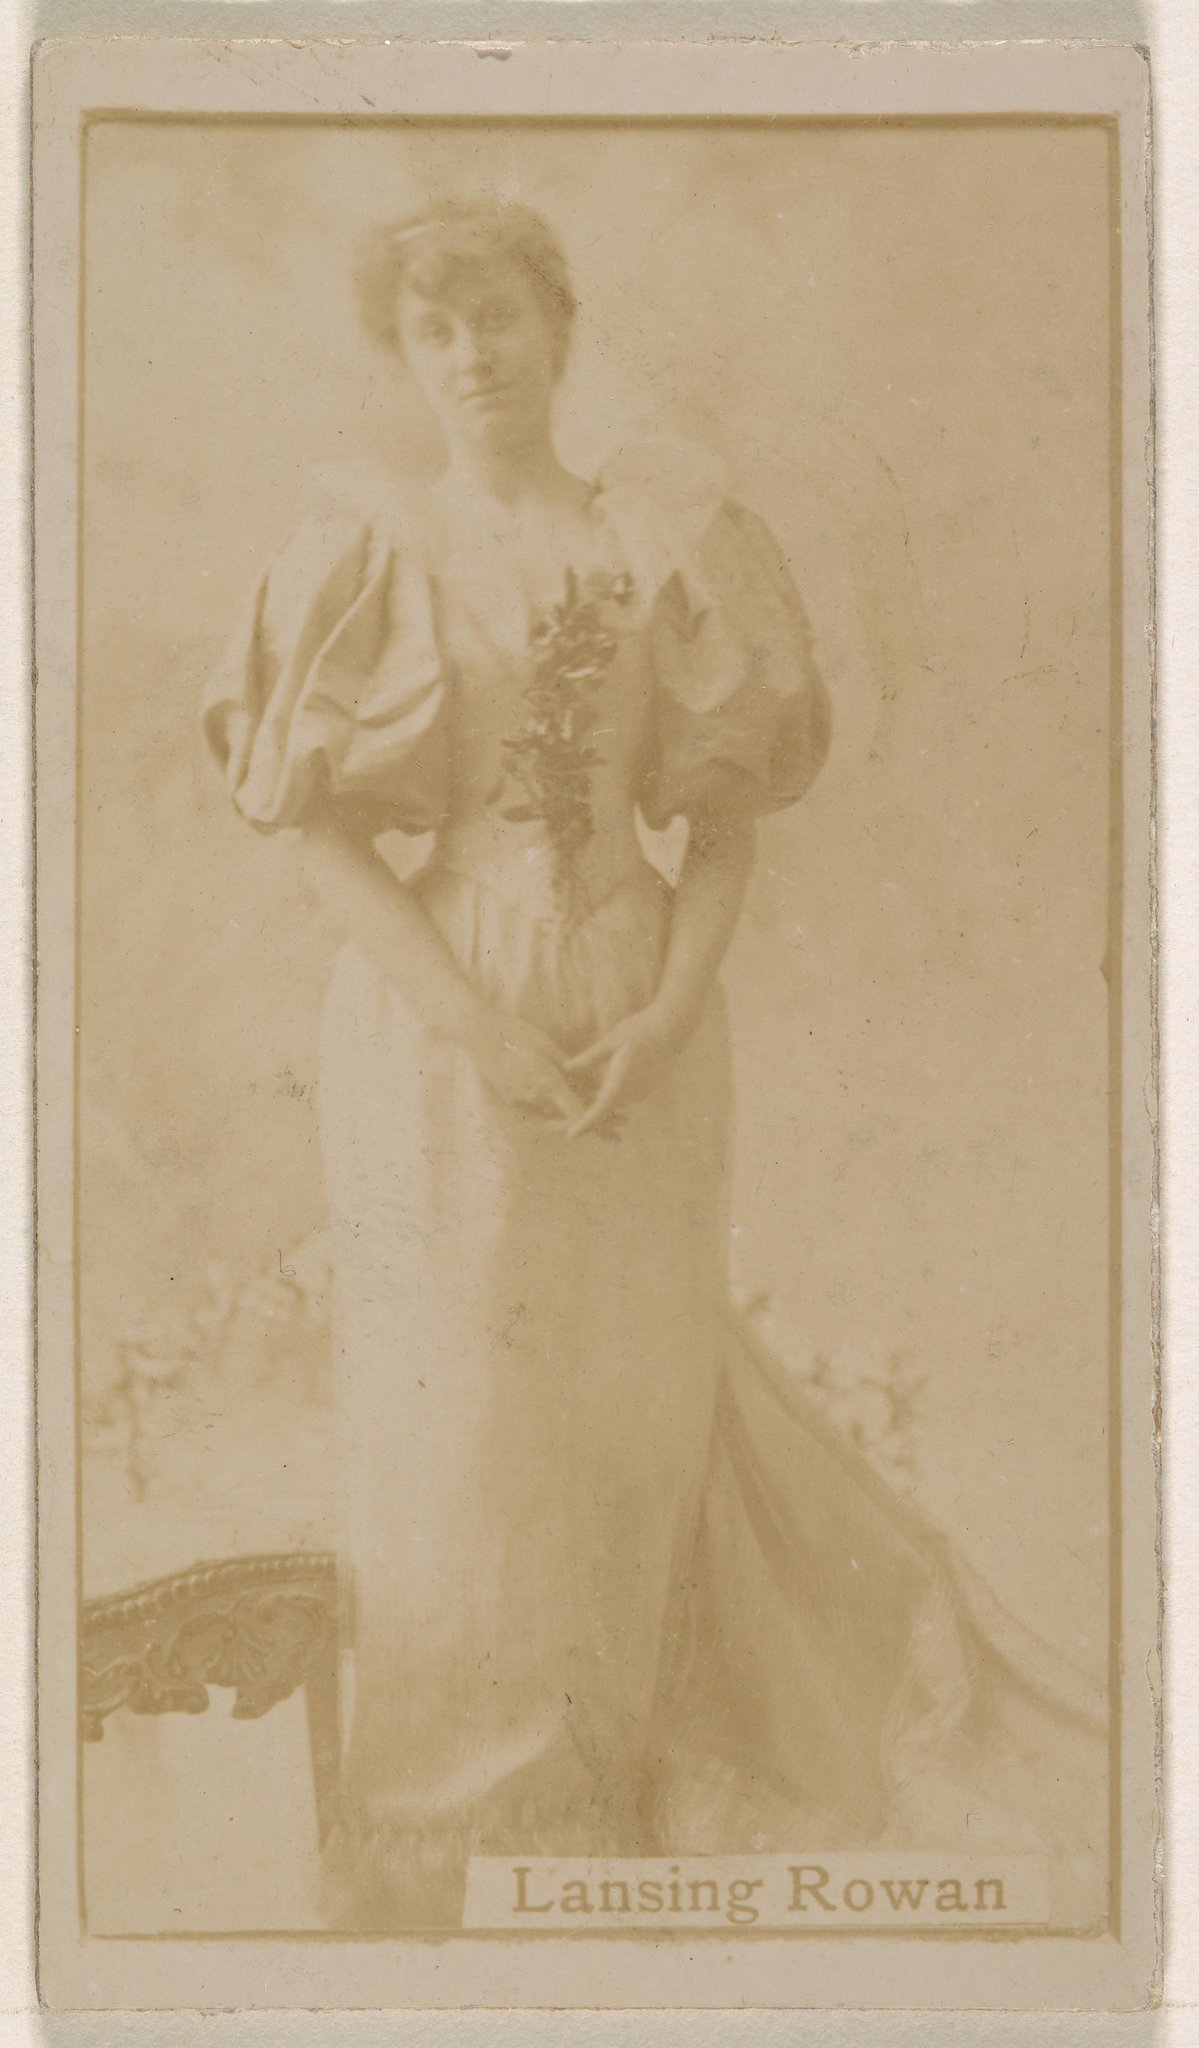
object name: photograph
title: Lansing Rowan, from the Actresses series (N245) issued by Kinney Brothers to promote Sweet Caporal Cigarettes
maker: kinney brothers tobacco company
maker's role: publisher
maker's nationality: american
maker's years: 1869-2011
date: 1890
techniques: albumen silver print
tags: portraits,women,actresses